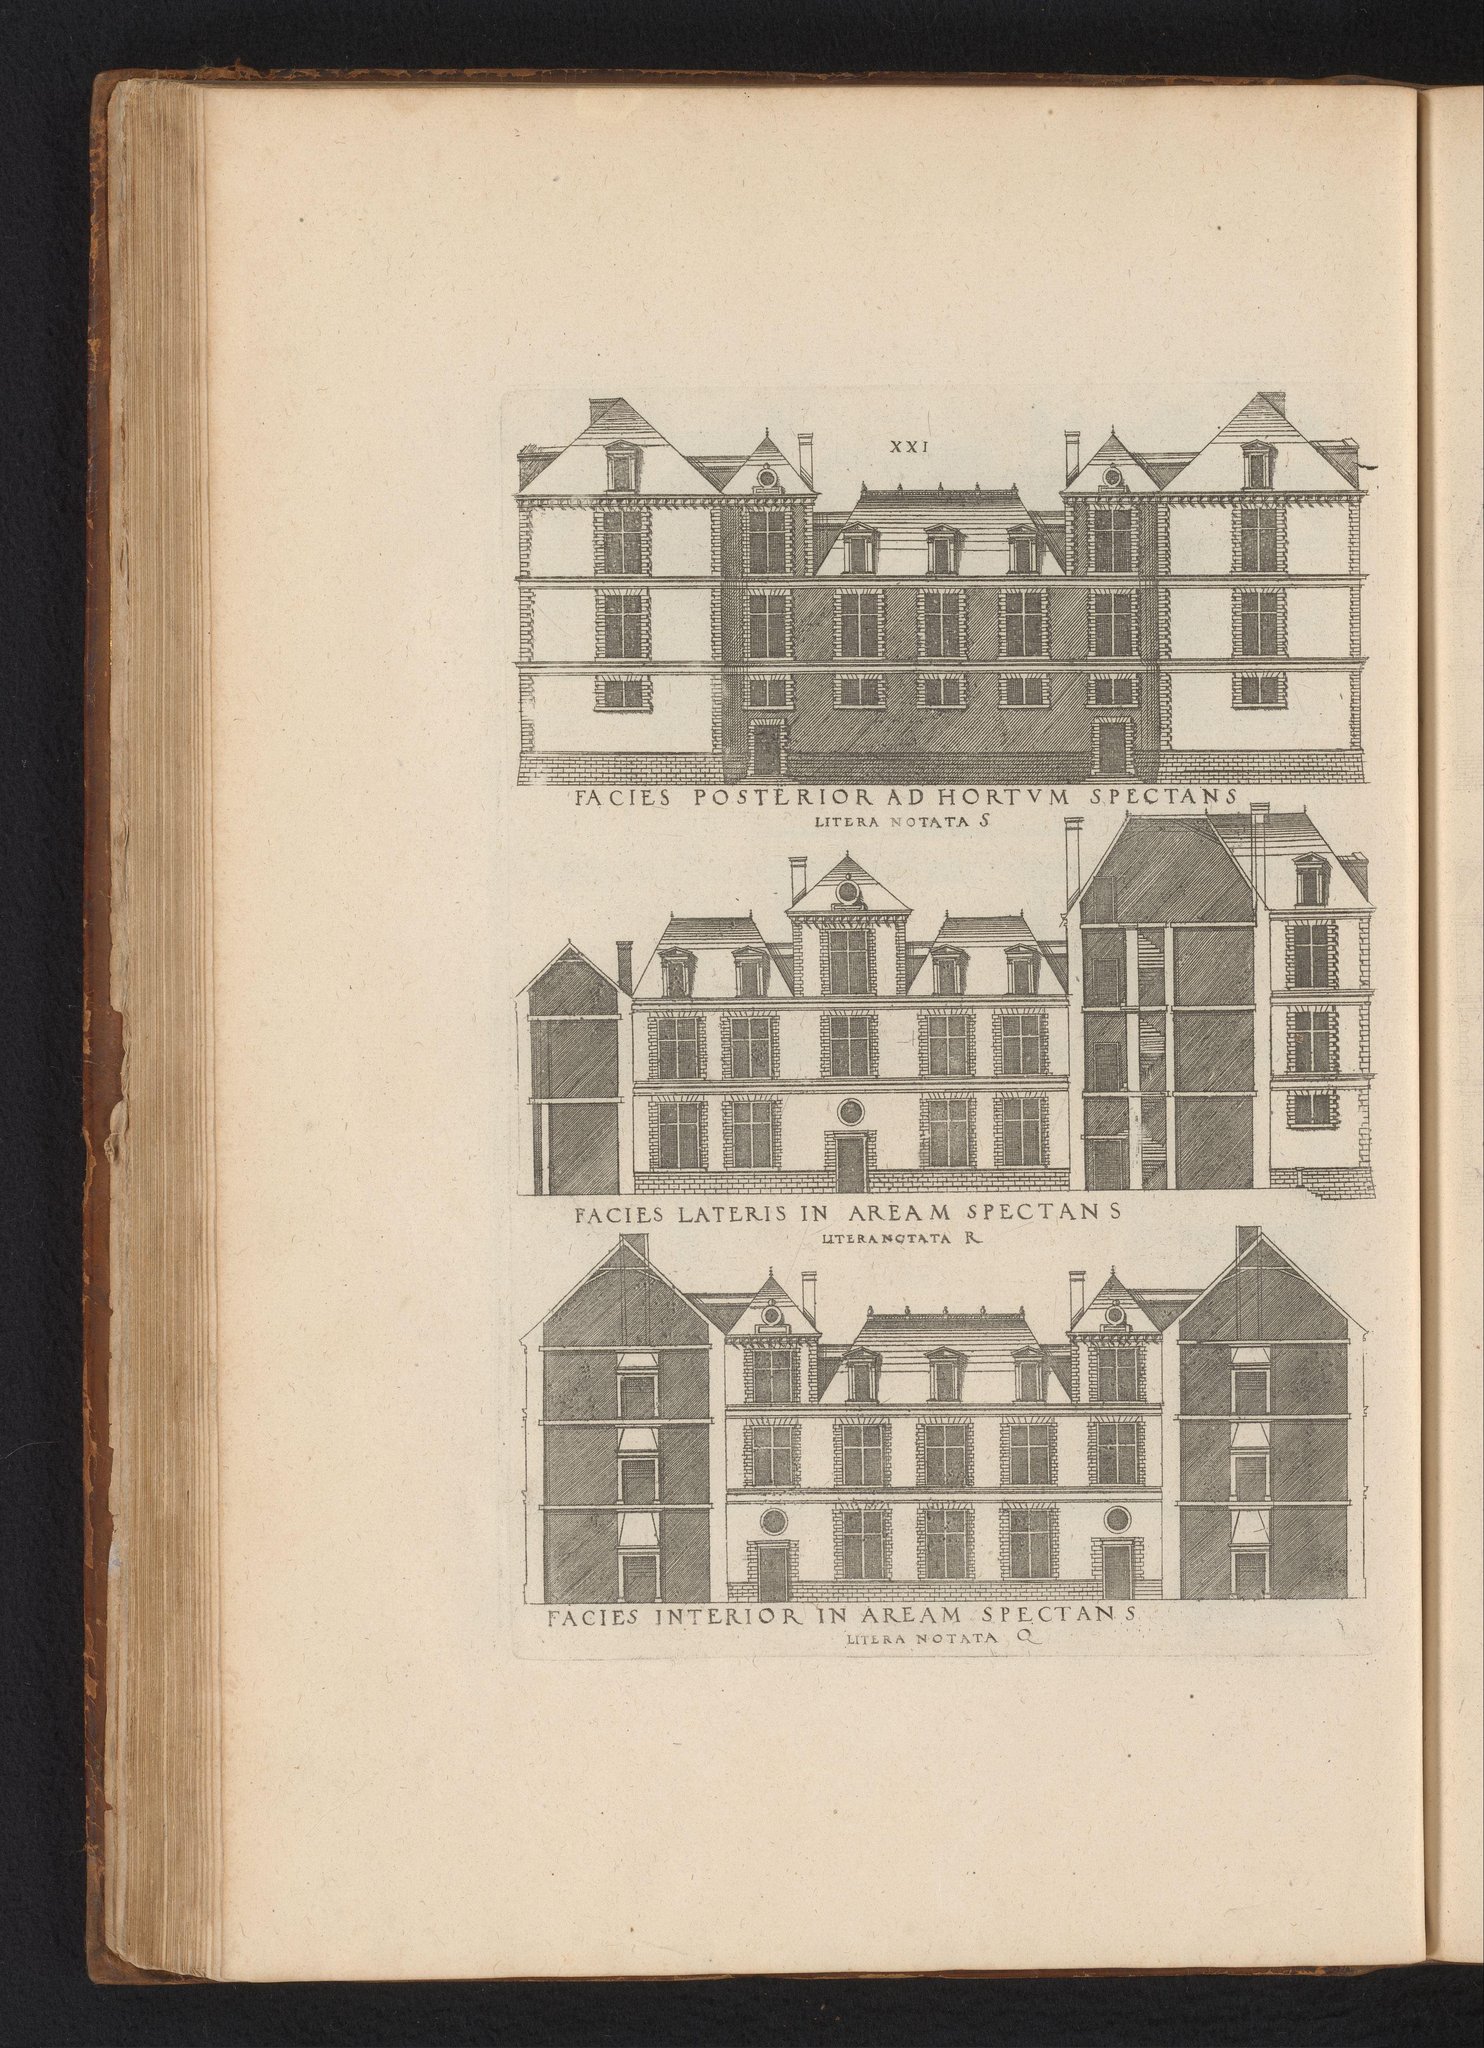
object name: ornament print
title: Voor-, zij- en achtergevel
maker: jacques androuet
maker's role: draughtsman, print maker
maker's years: 1515-1584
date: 1559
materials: paper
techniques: etching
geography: paris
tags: architectural design or model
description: Voor-, zij- en achtergevel. Aanzicht en plattegrond van architectuur. Genummerd: XXI. Onderdeel van 'De architectura Iacobi Androuetii du Cerceau' (1559): 69 etsen met 171 voorstellingen van architectuur en ornamentiek.